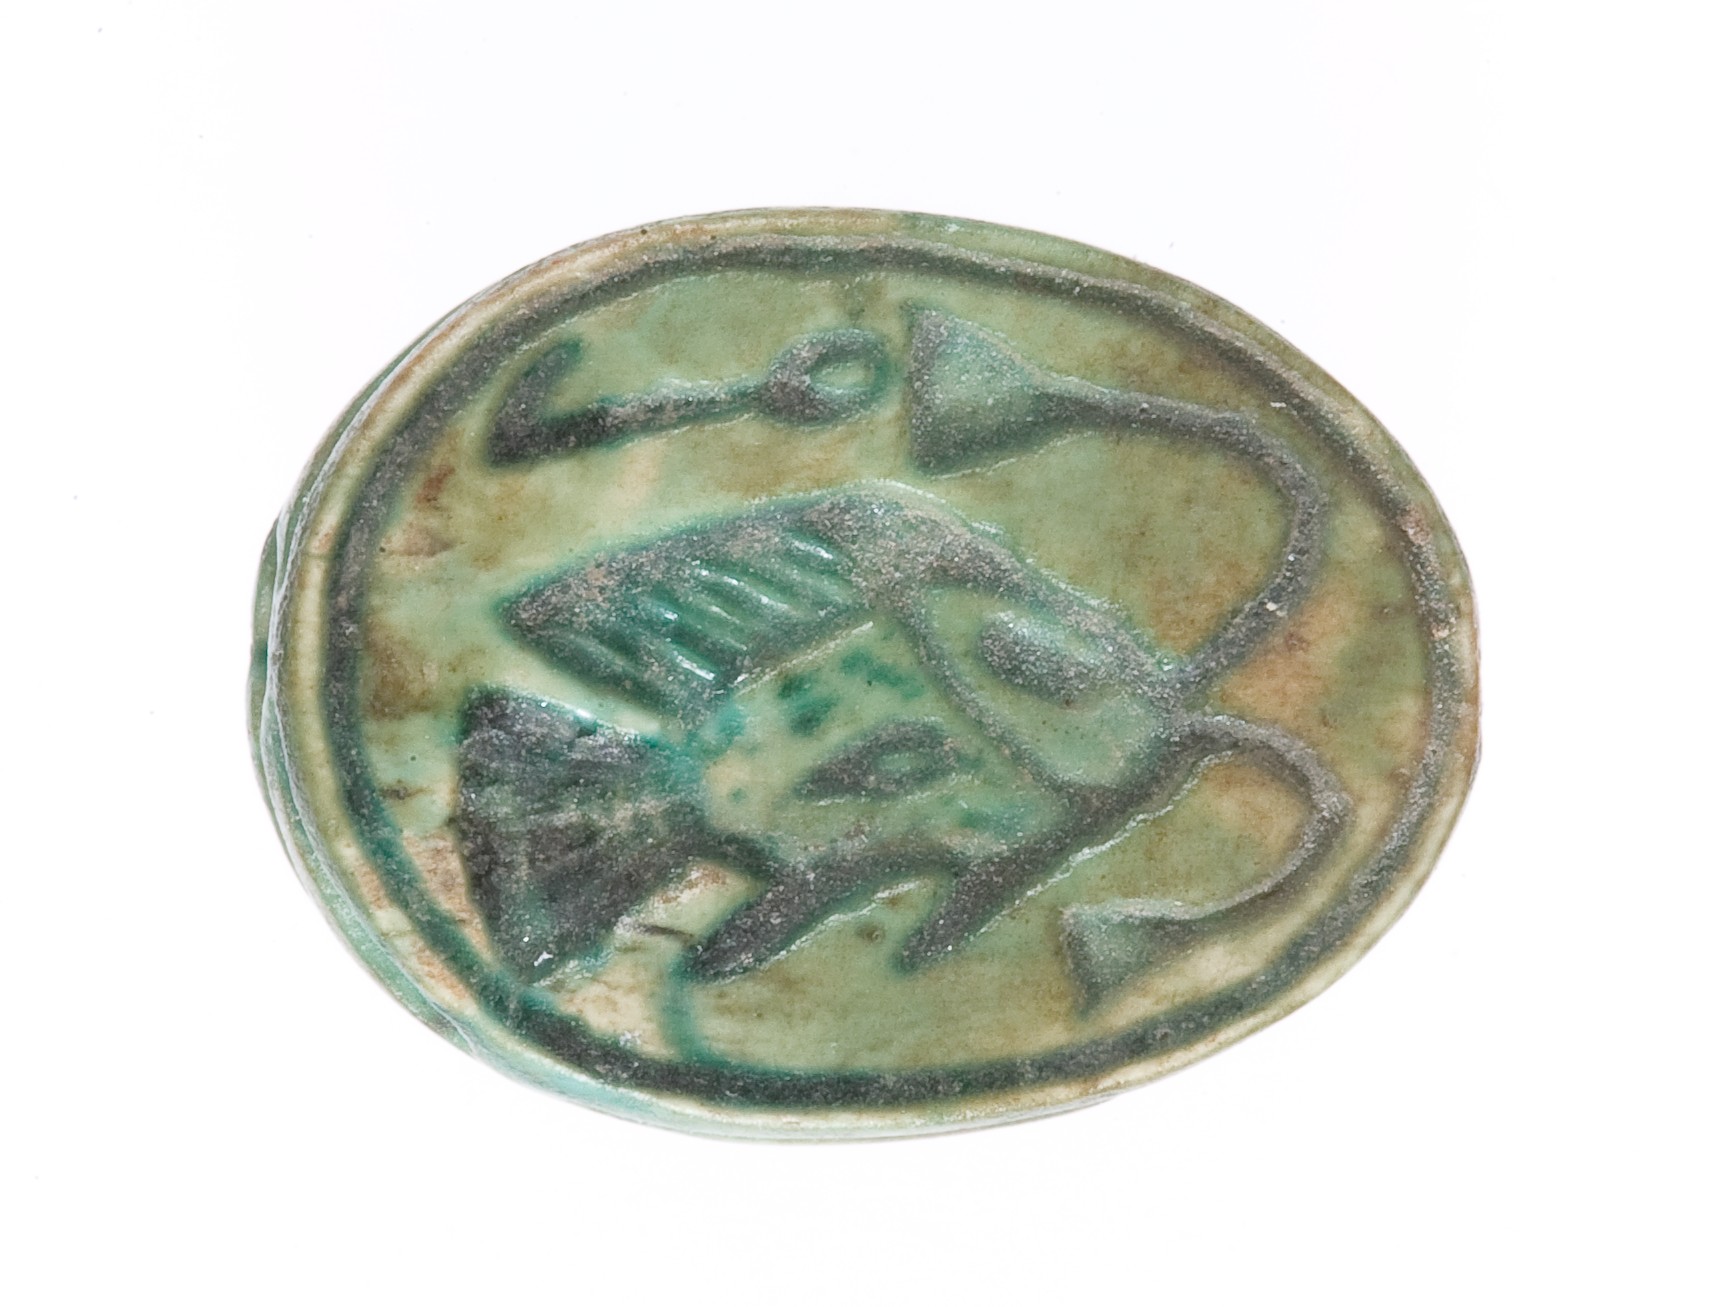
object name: scarab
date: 1550-1458 BCE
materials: stone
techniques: glazing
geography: egypt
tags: fish,scarabs